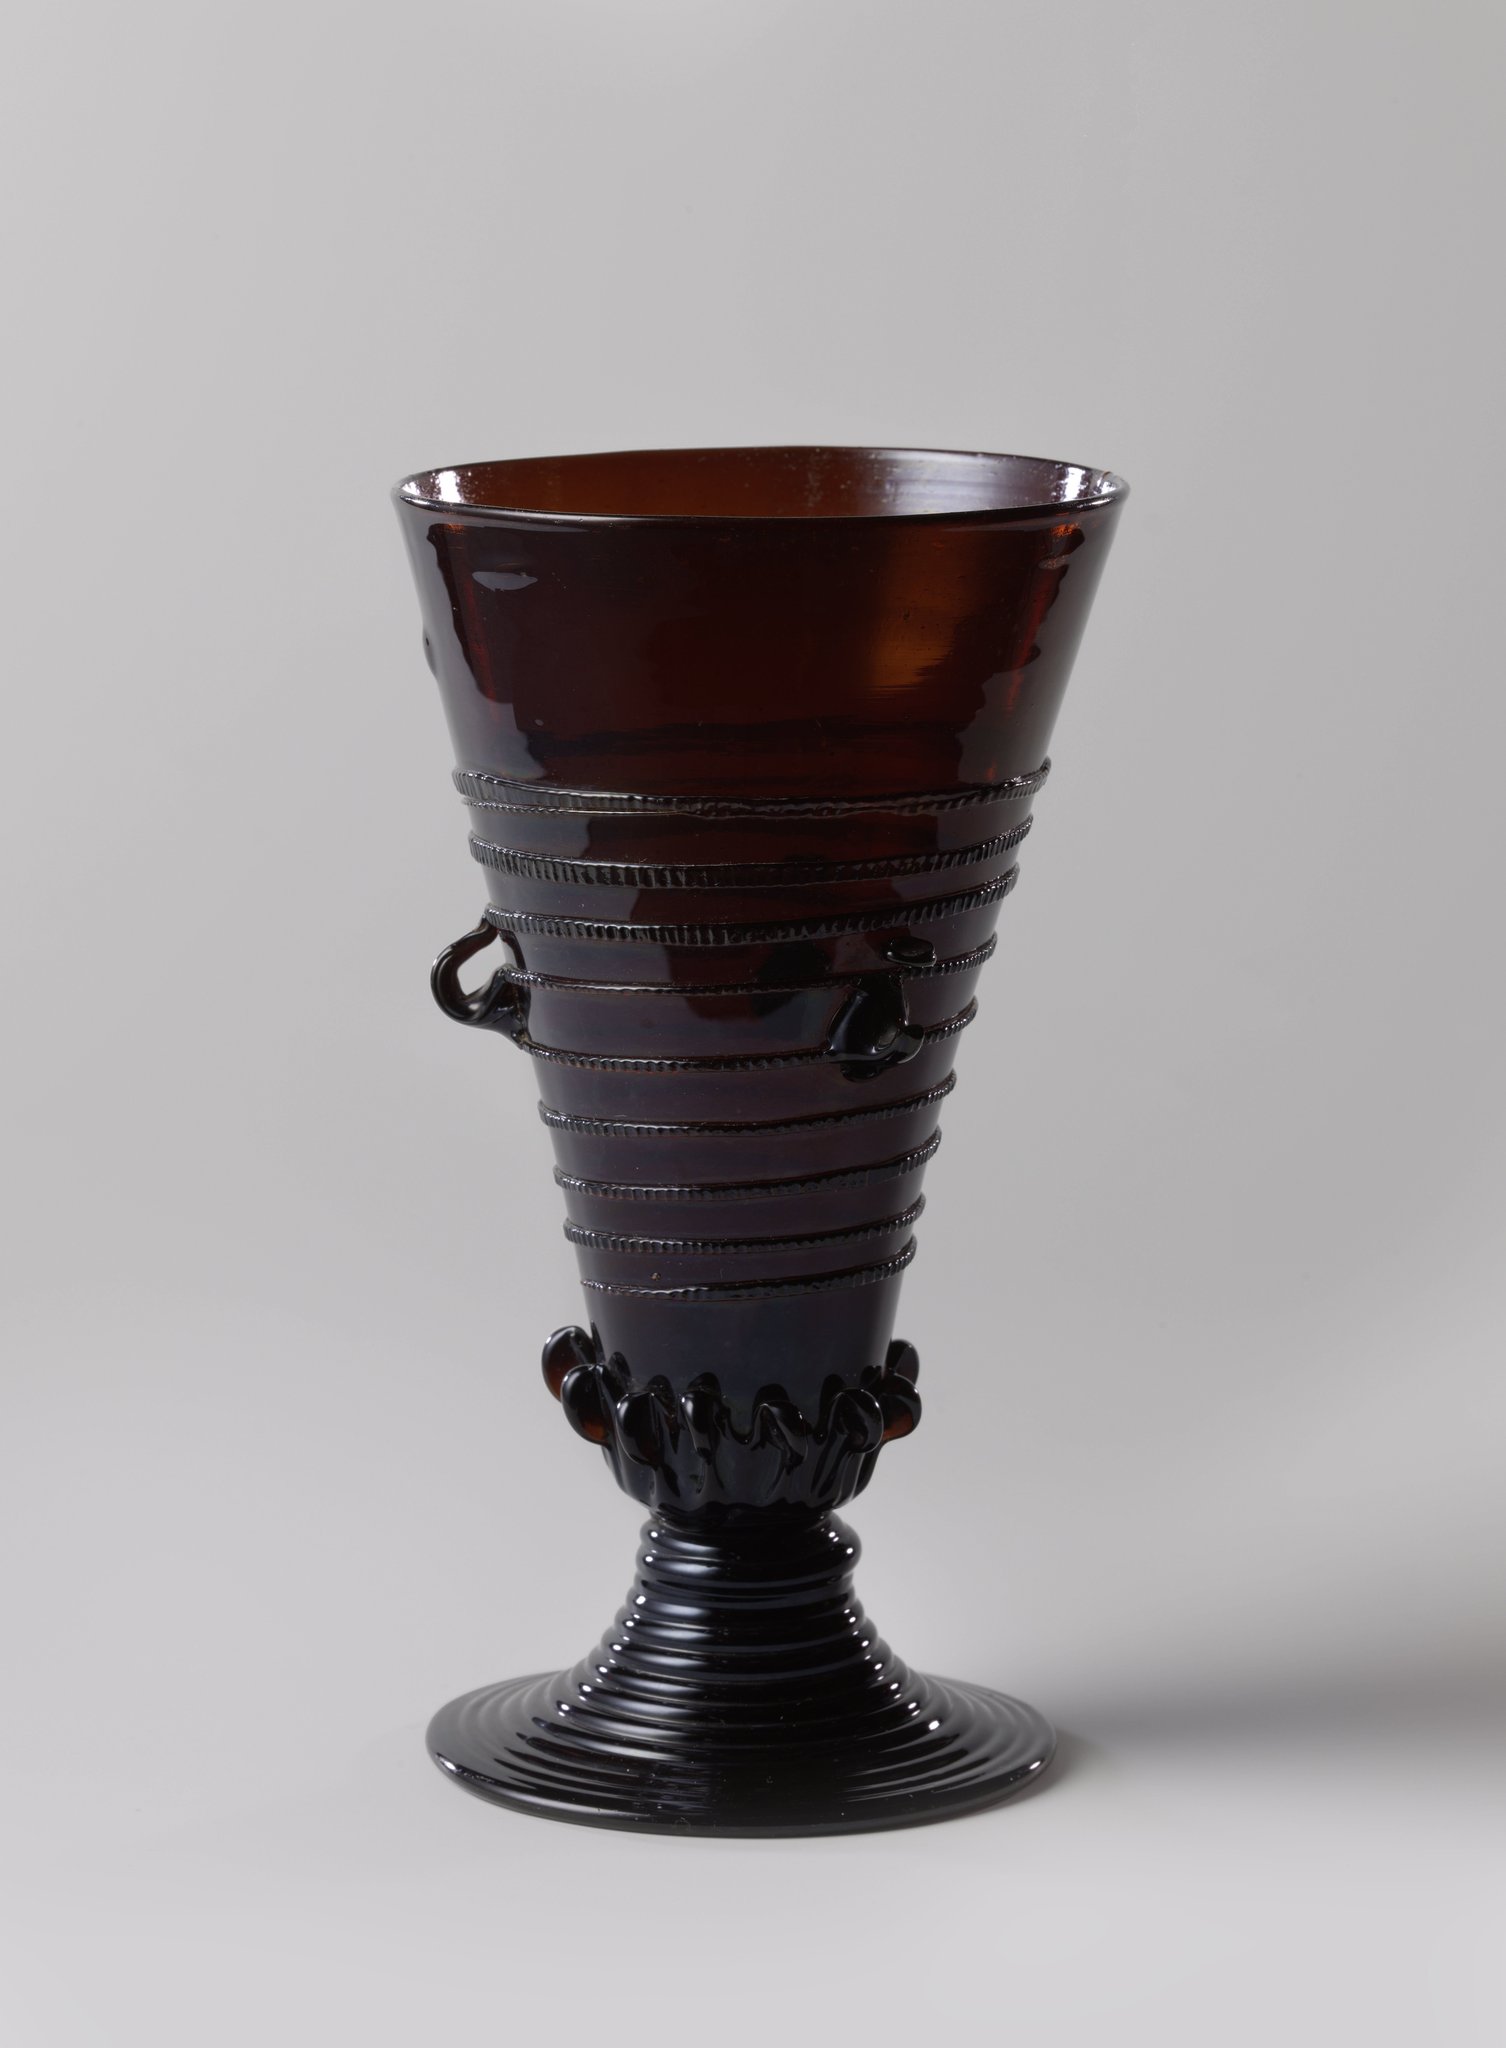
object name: ringbeker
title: Ringelbeker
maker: Anonymous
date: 1800-1900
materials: glass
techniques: glassblowing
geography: germany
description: Concave, uit een draad gesponnen voet. Trechtervormige kelk, waaromheen spiraalsgewijs een geribde draad is gelegd. Aan de onderzijde van de kelk druppelvormige ornamenten. Halverweg de kelk drie ogen.